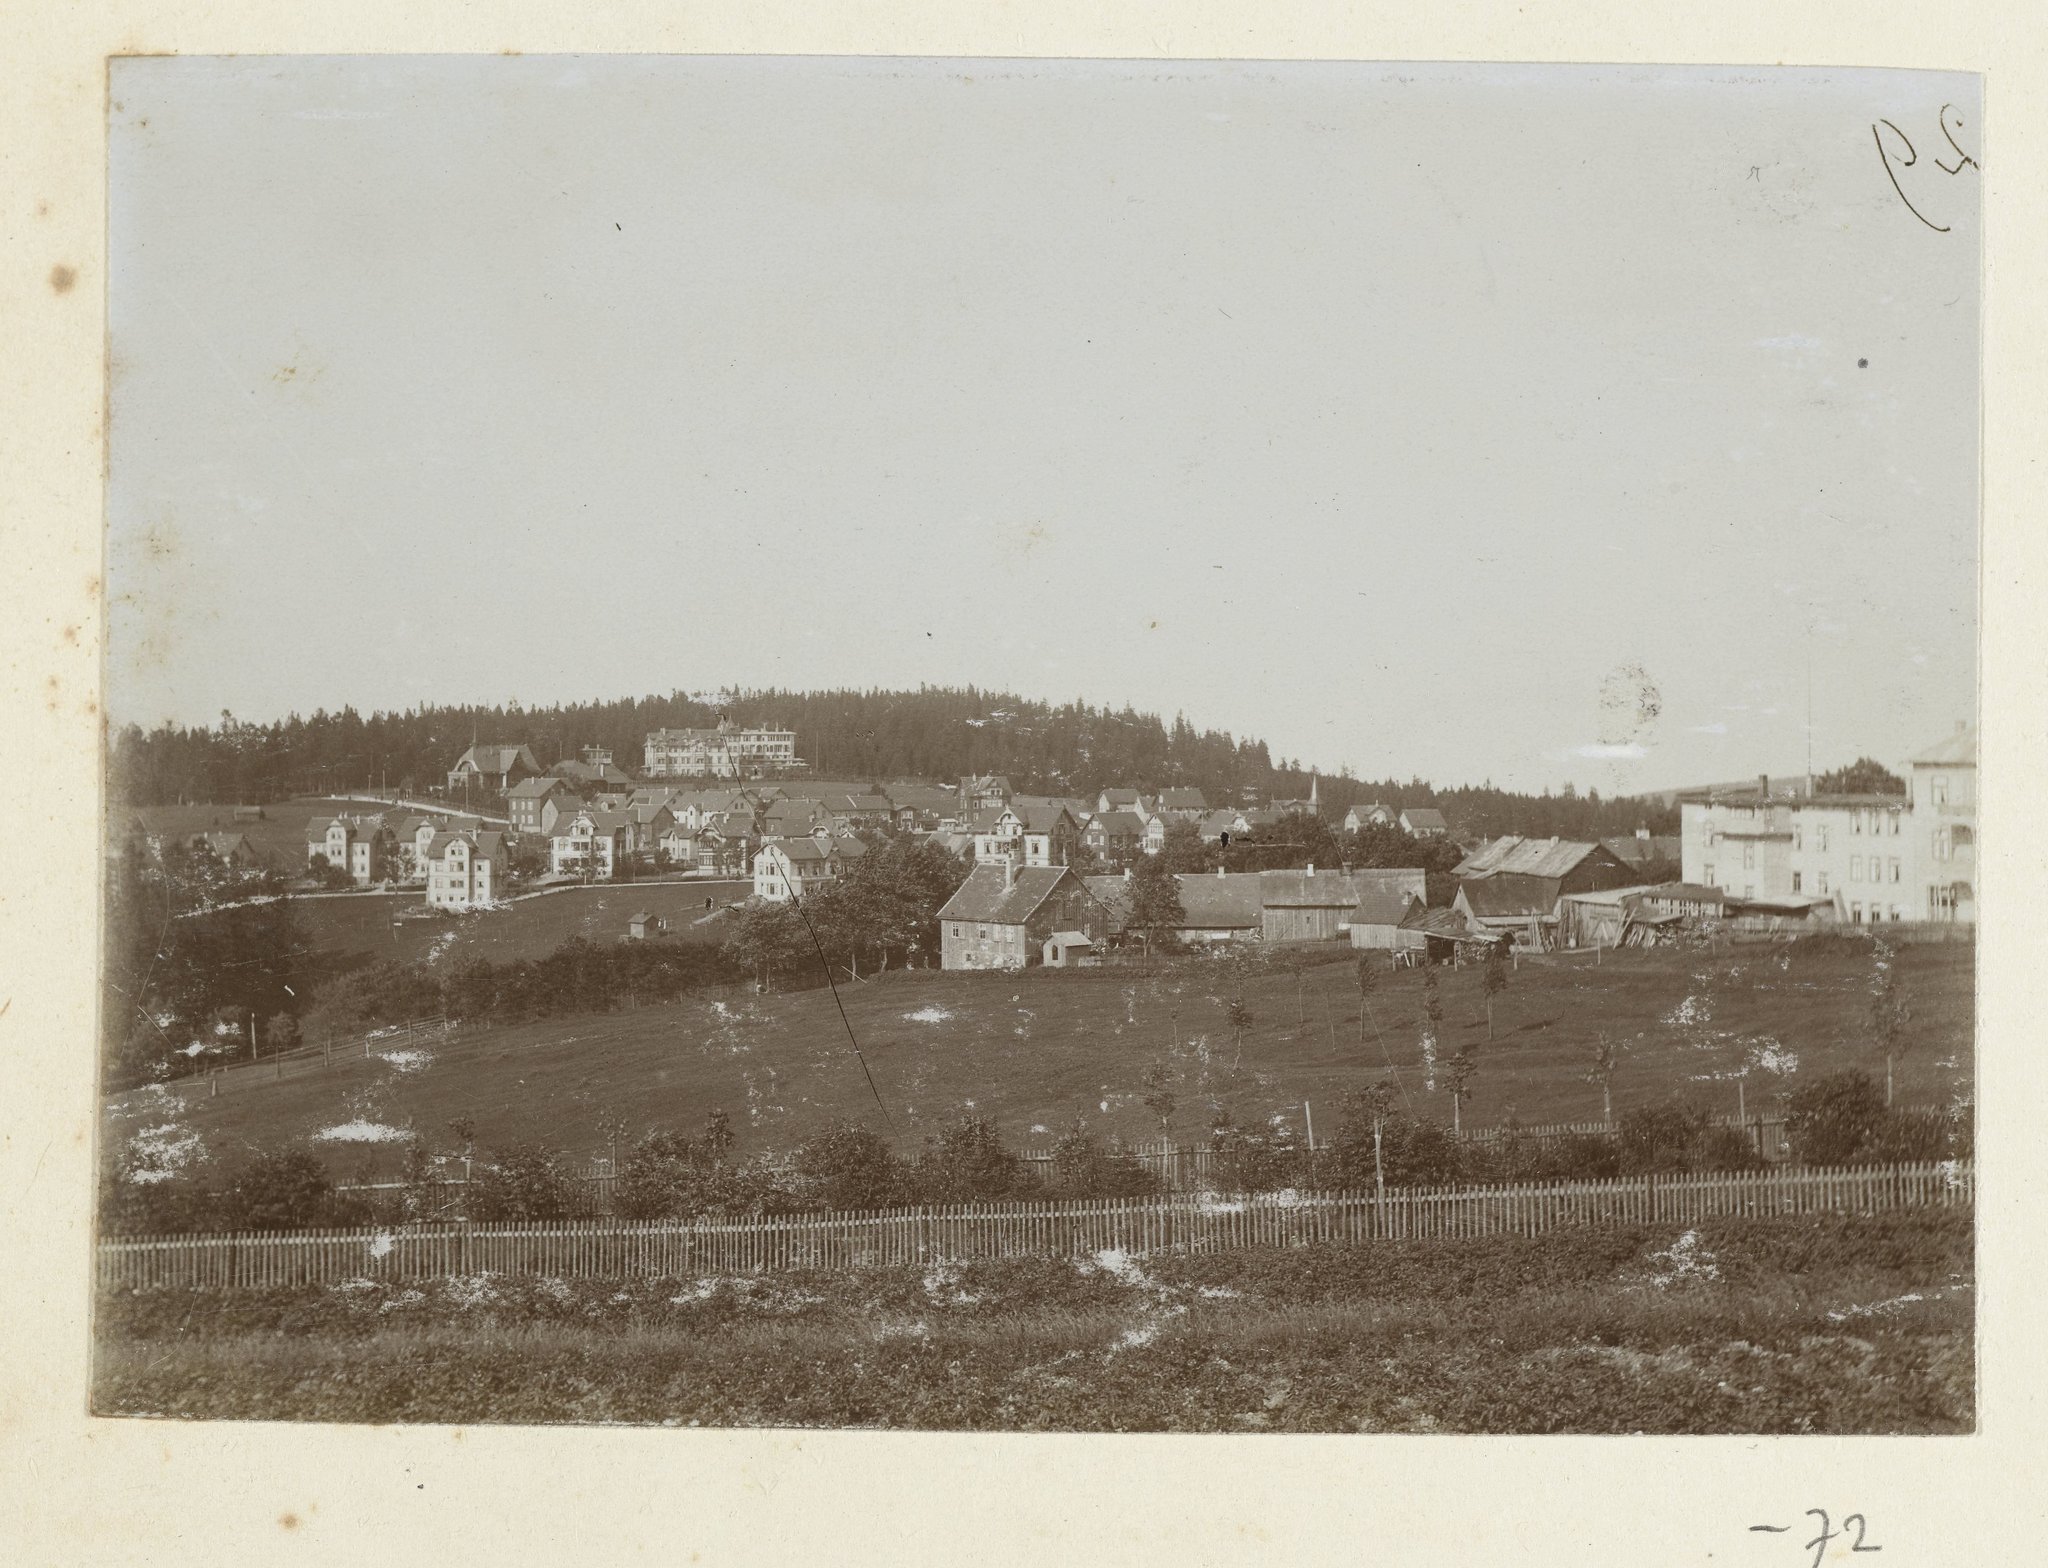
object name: photograph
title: Gezicht op een stadje in de Harz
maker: geldolph adriaan kessler (dolph)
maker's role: fotograaf, industrieel, voetballer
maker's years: 1884-1945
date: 1903-1908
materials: cardboard, photographic support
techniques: gelatin silver print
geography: harz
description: Gezicht op een stadje in een heuvelachtig landschap in vermoedelijk de Harz. Onderdeel van het fotoalbum van Dolph Kessler met opnamen die hij maakte tijdens zijn verblijf in Engeland en op een wereldreis die hij als secretaris van Henri Deterding (directeur Koninklijke Olie) ondernam naar Nederlands-Indië, Japan, China en de Verenigde Staten, tussen 1906 en 1908.